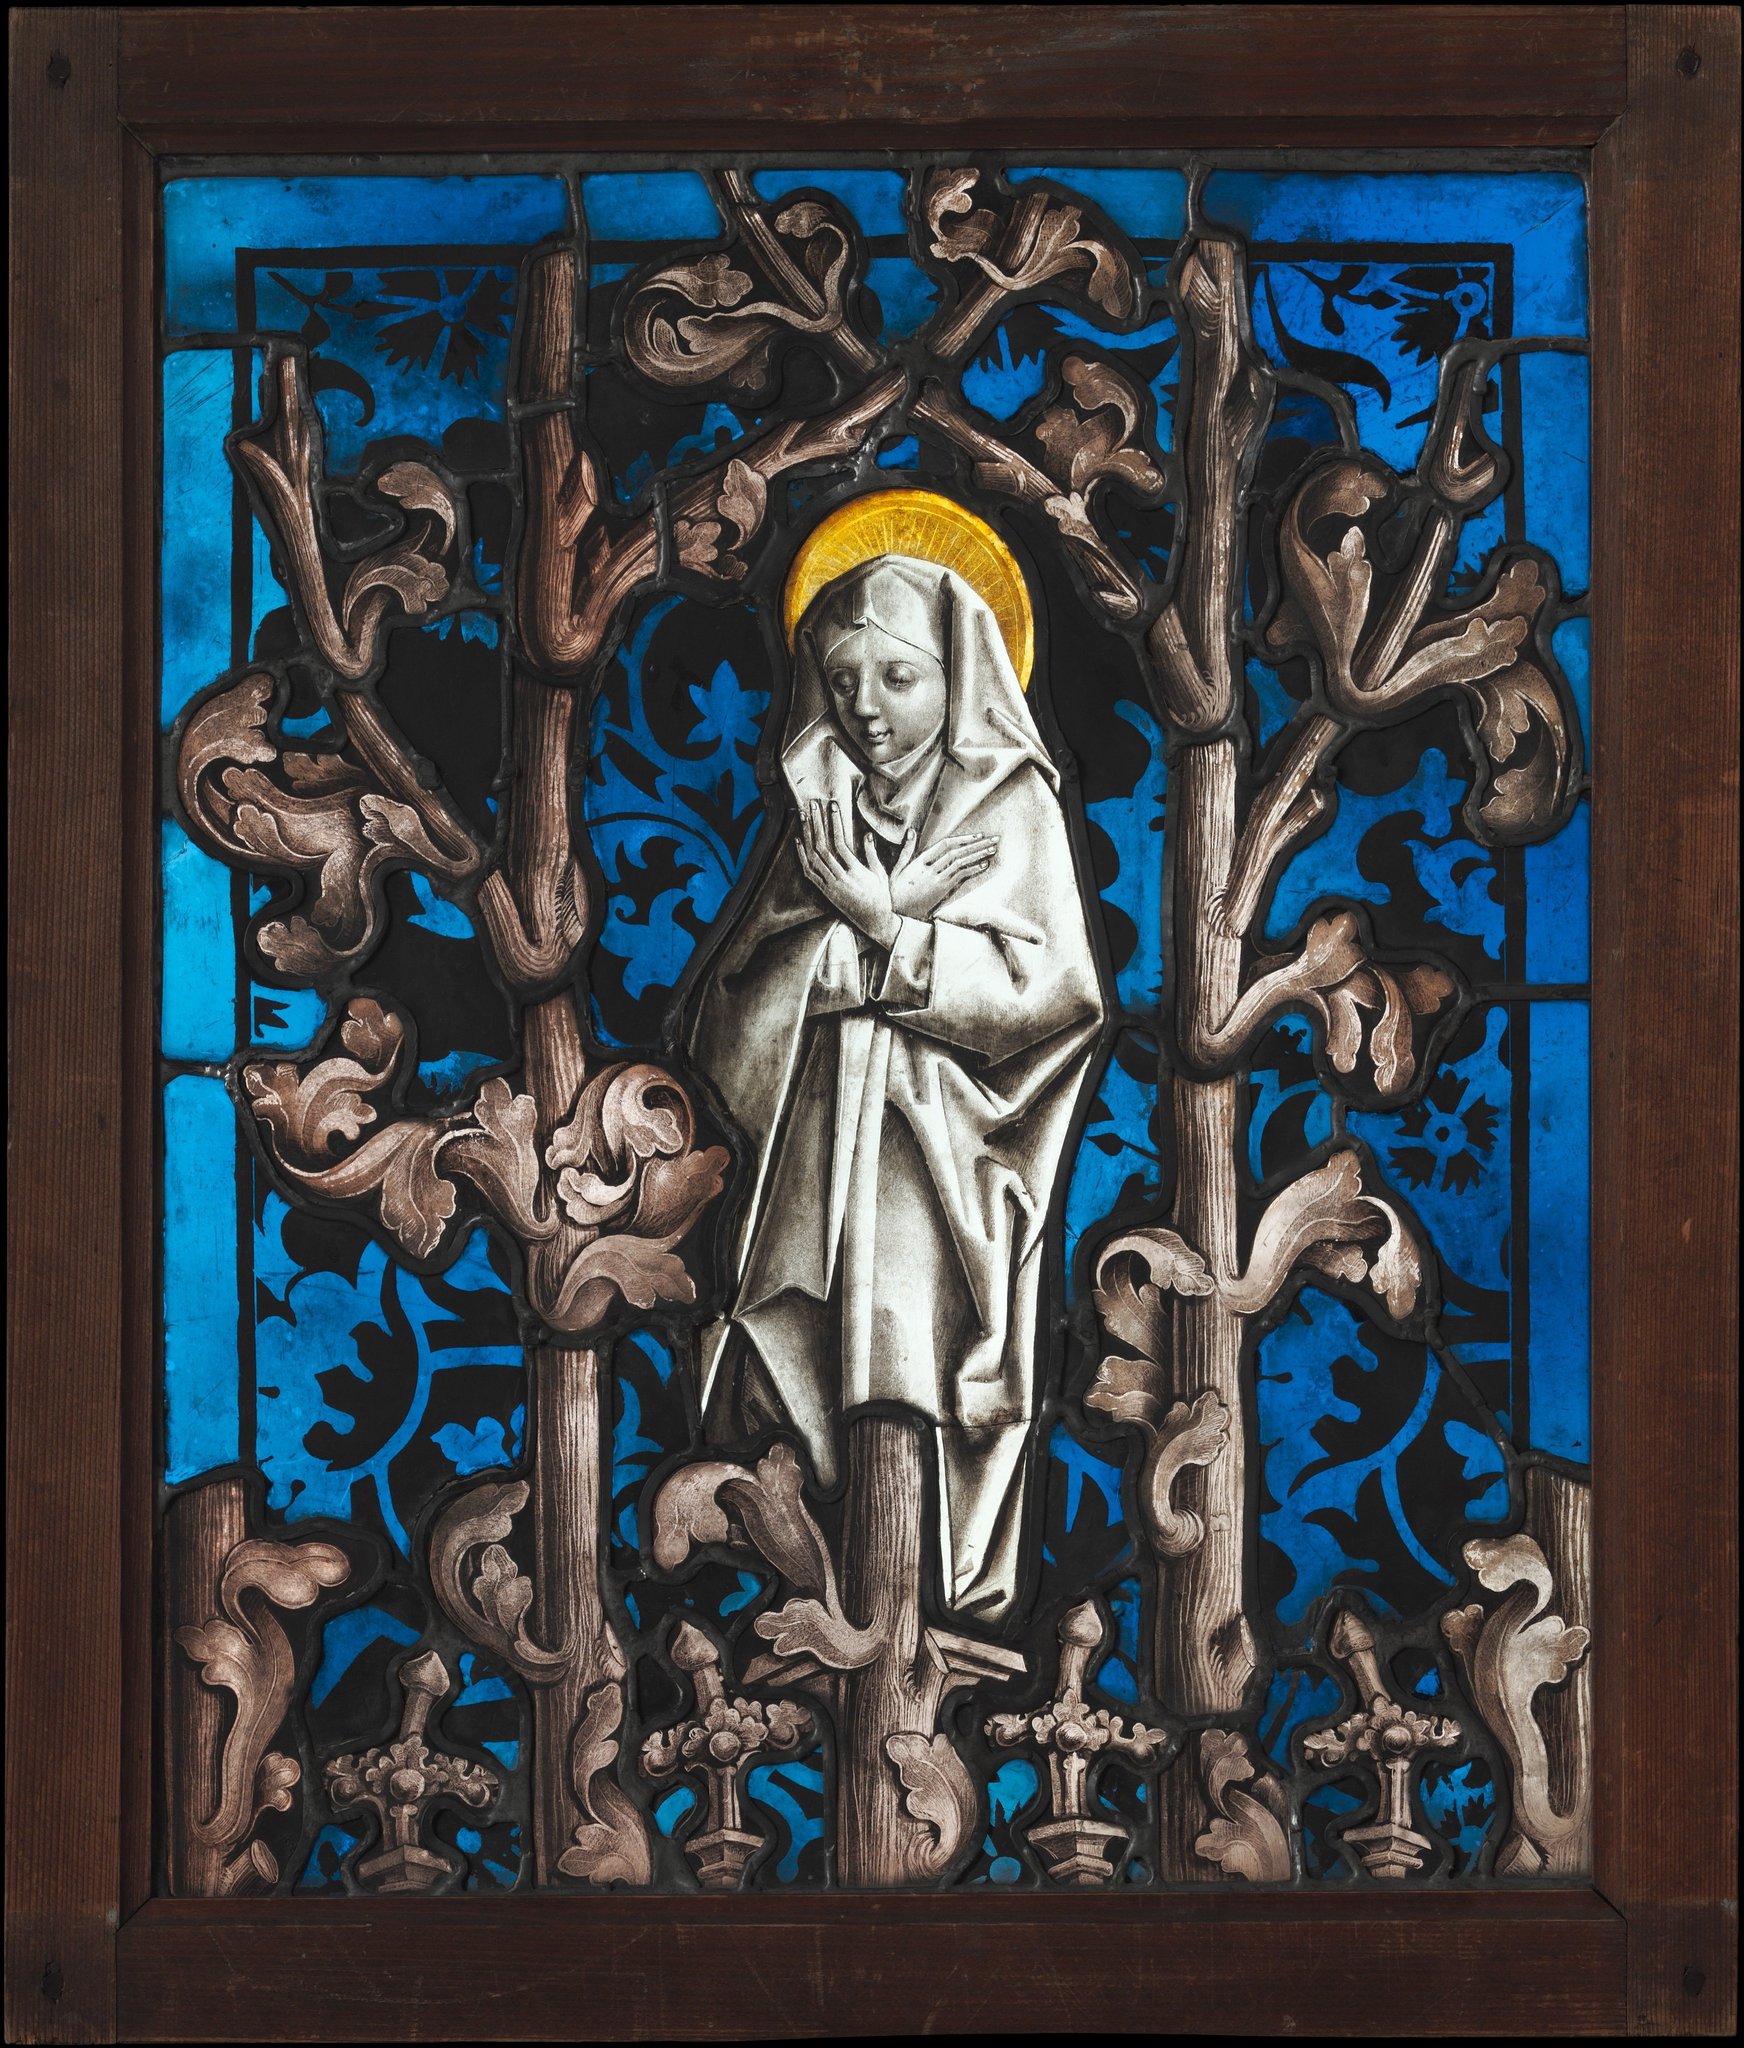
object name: stained glass panel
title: The Mater Dolorosa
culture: german, south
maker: lautenbach master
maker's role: artist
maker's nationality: german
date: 1480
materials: glass, metal, paint, pigment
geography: germany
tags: virgin mary